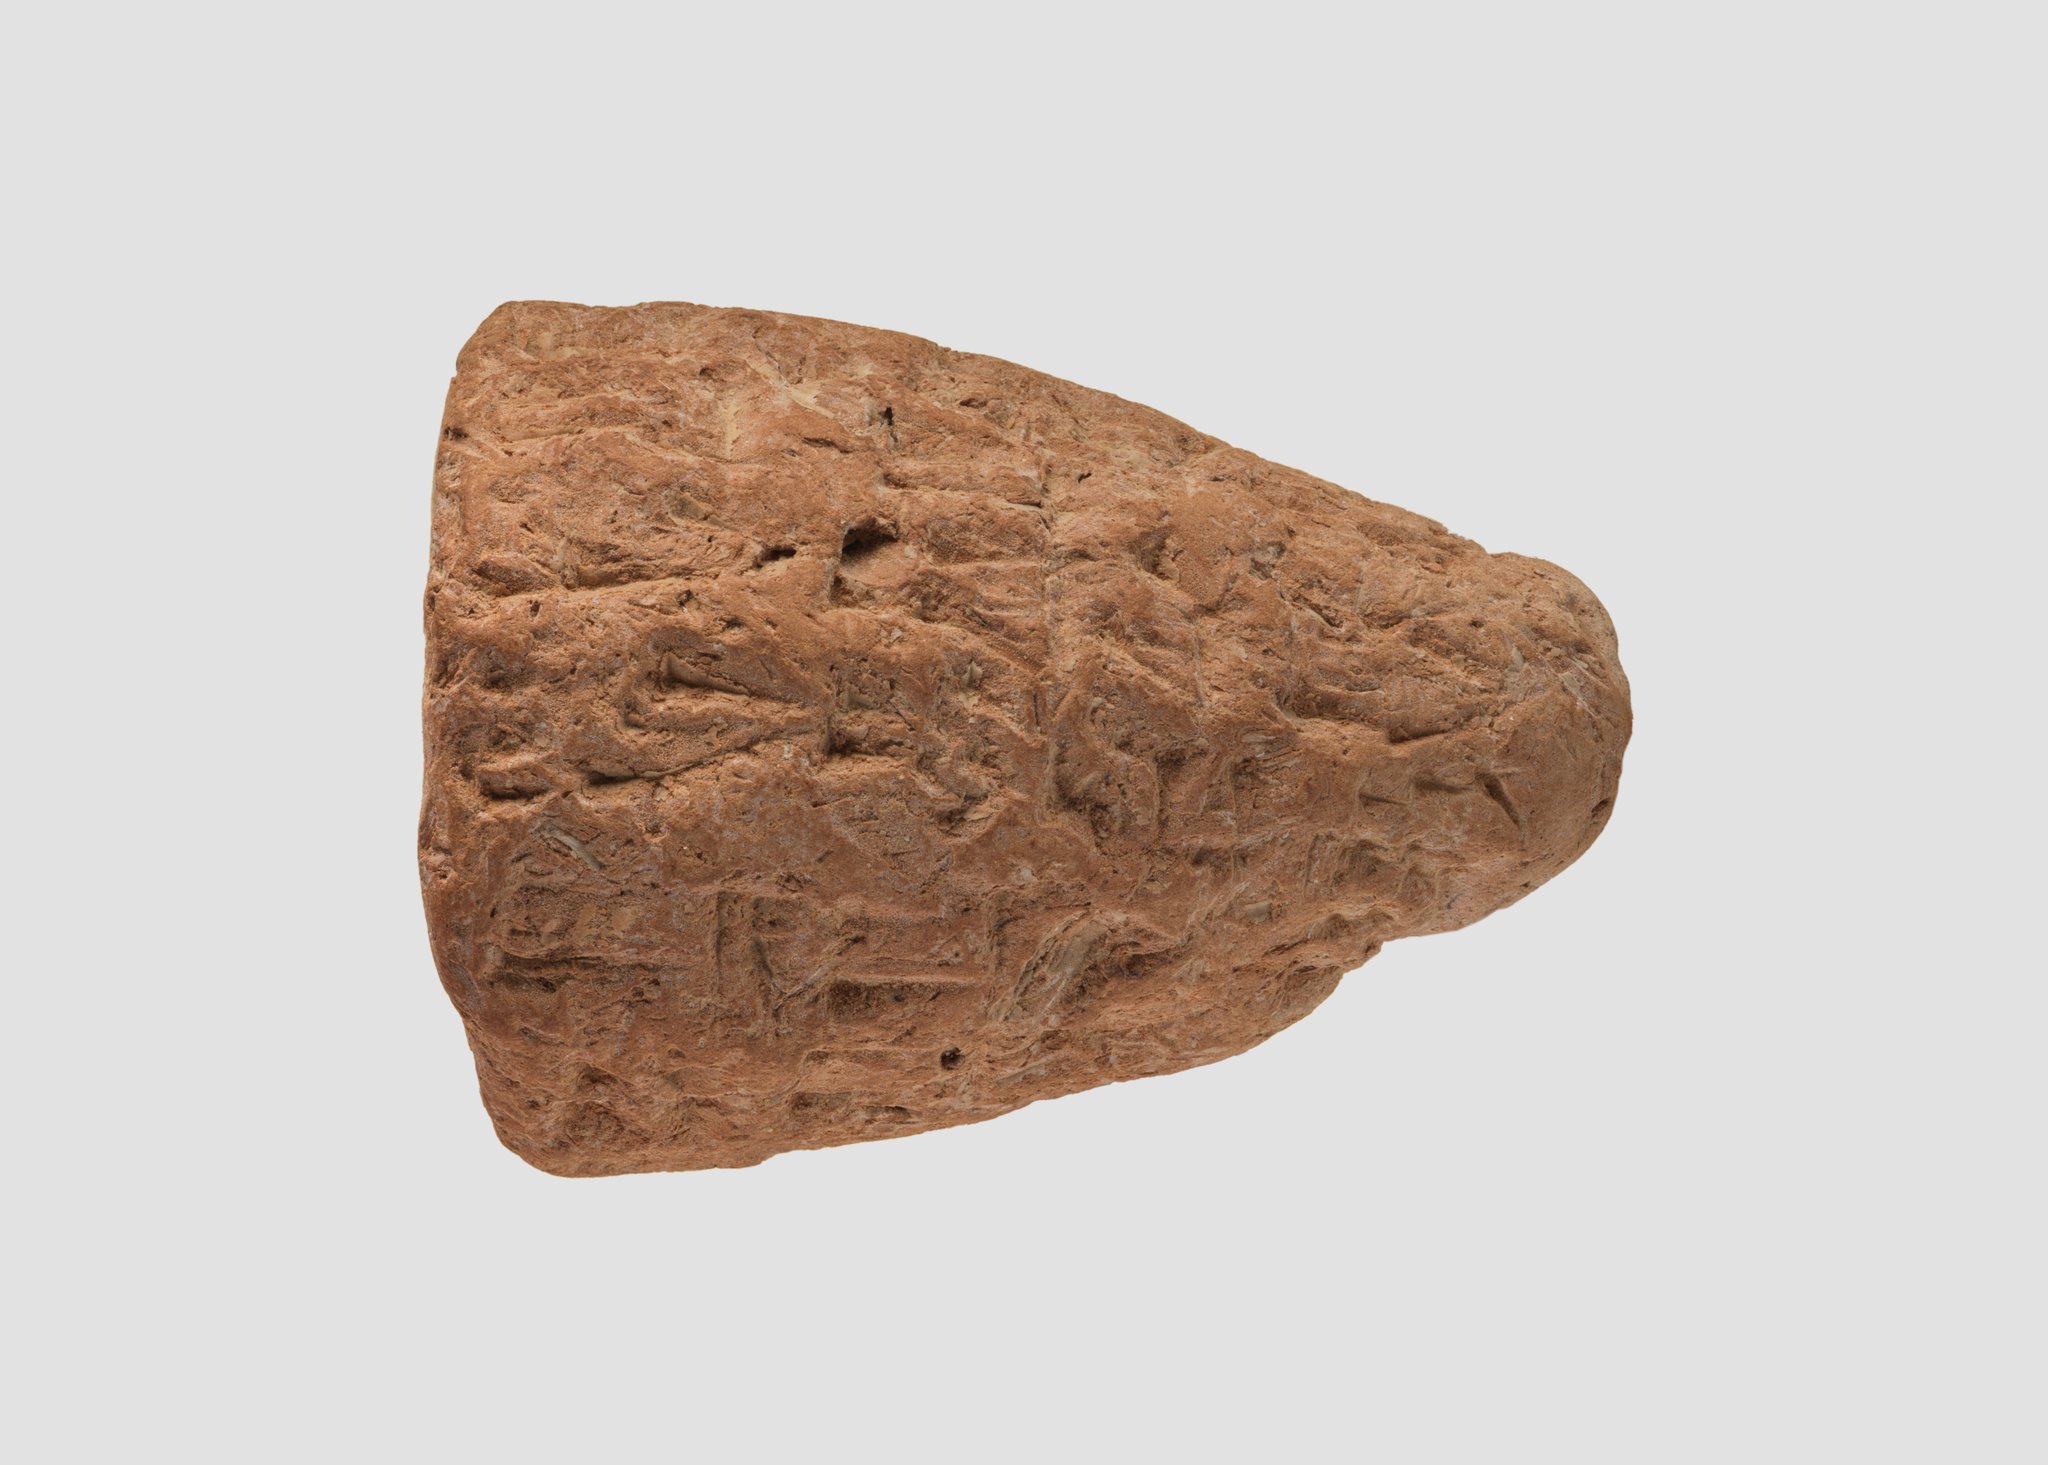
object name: cuneiform cone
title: Votive cone with cuneiform inscription of Sin-Kashid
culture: babylonian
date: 1867-1835 BCE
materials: clay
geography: mesopotamia